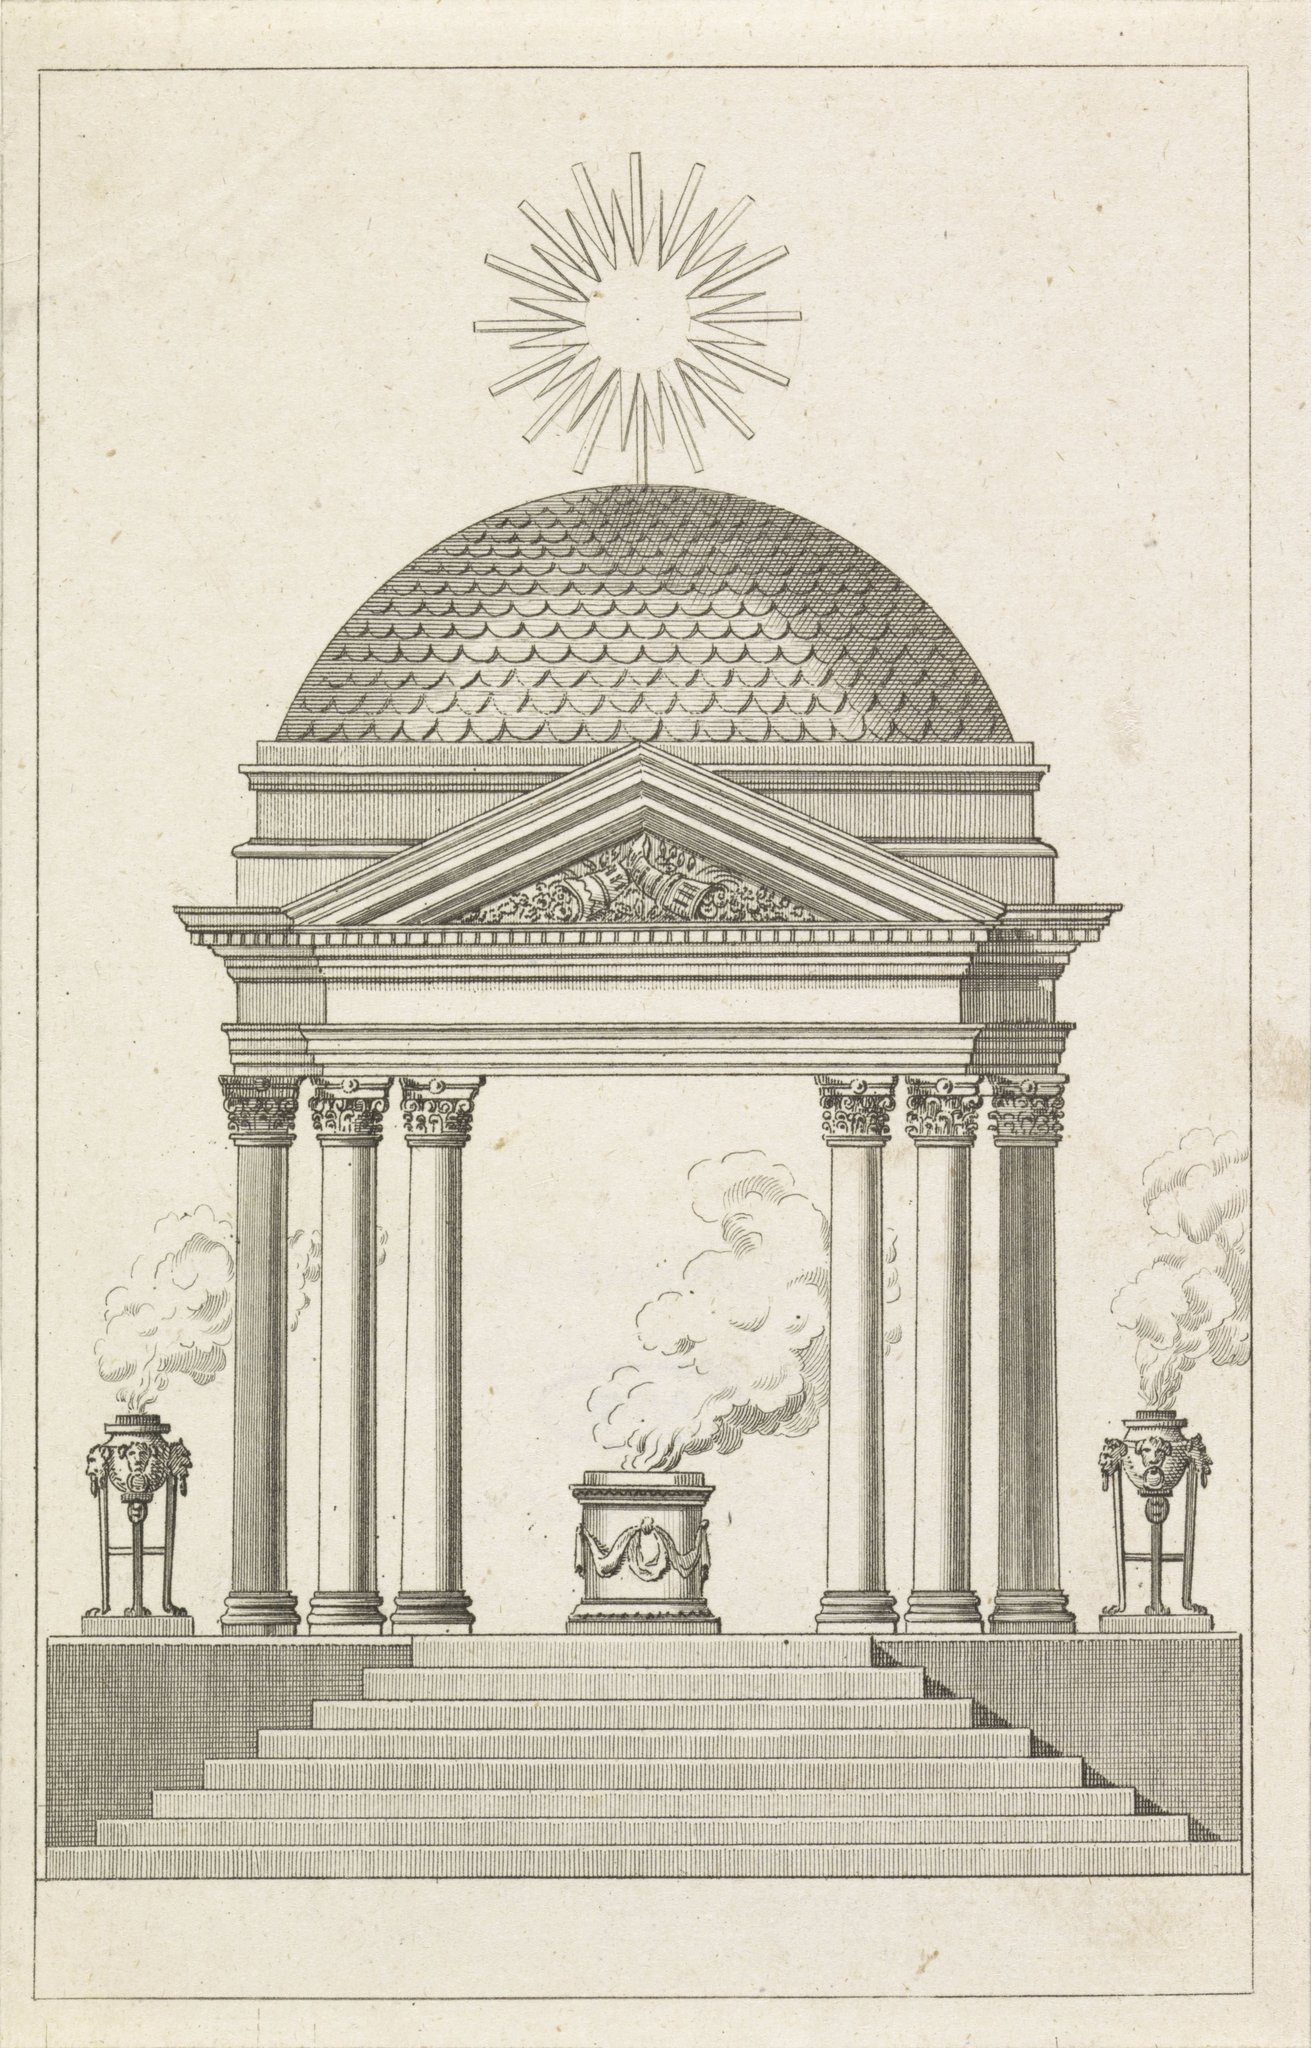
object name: print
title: Erepoort aan de Haarlemmerpoort, 1816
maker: antoni zürcher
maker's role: print maker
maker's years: 1754-1837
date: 1816-1817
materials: paper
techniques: engraving, etching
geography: netherlands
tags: the hague, anna paulowna romanowa, william ii of the netherlands, public festivities on the occasion of royal events (+ decorated staff, portable structure ~ festive activities), triumphal arch, amsterdam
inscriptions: collector's mark: Lugt 2228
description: Erepoort in de vorm van een tempel met koepel en zes zuilen, met bovenop een stralende zon. Opgericht bij de Haarlemmerpoort. Bij de prent een tekstfragment met een beschrijving van de decoratie. Illustraties van de decoraties opgesteld bij het bezoek van de prins en prinses van Oranje aan Amsterdam op 19 september 1816.